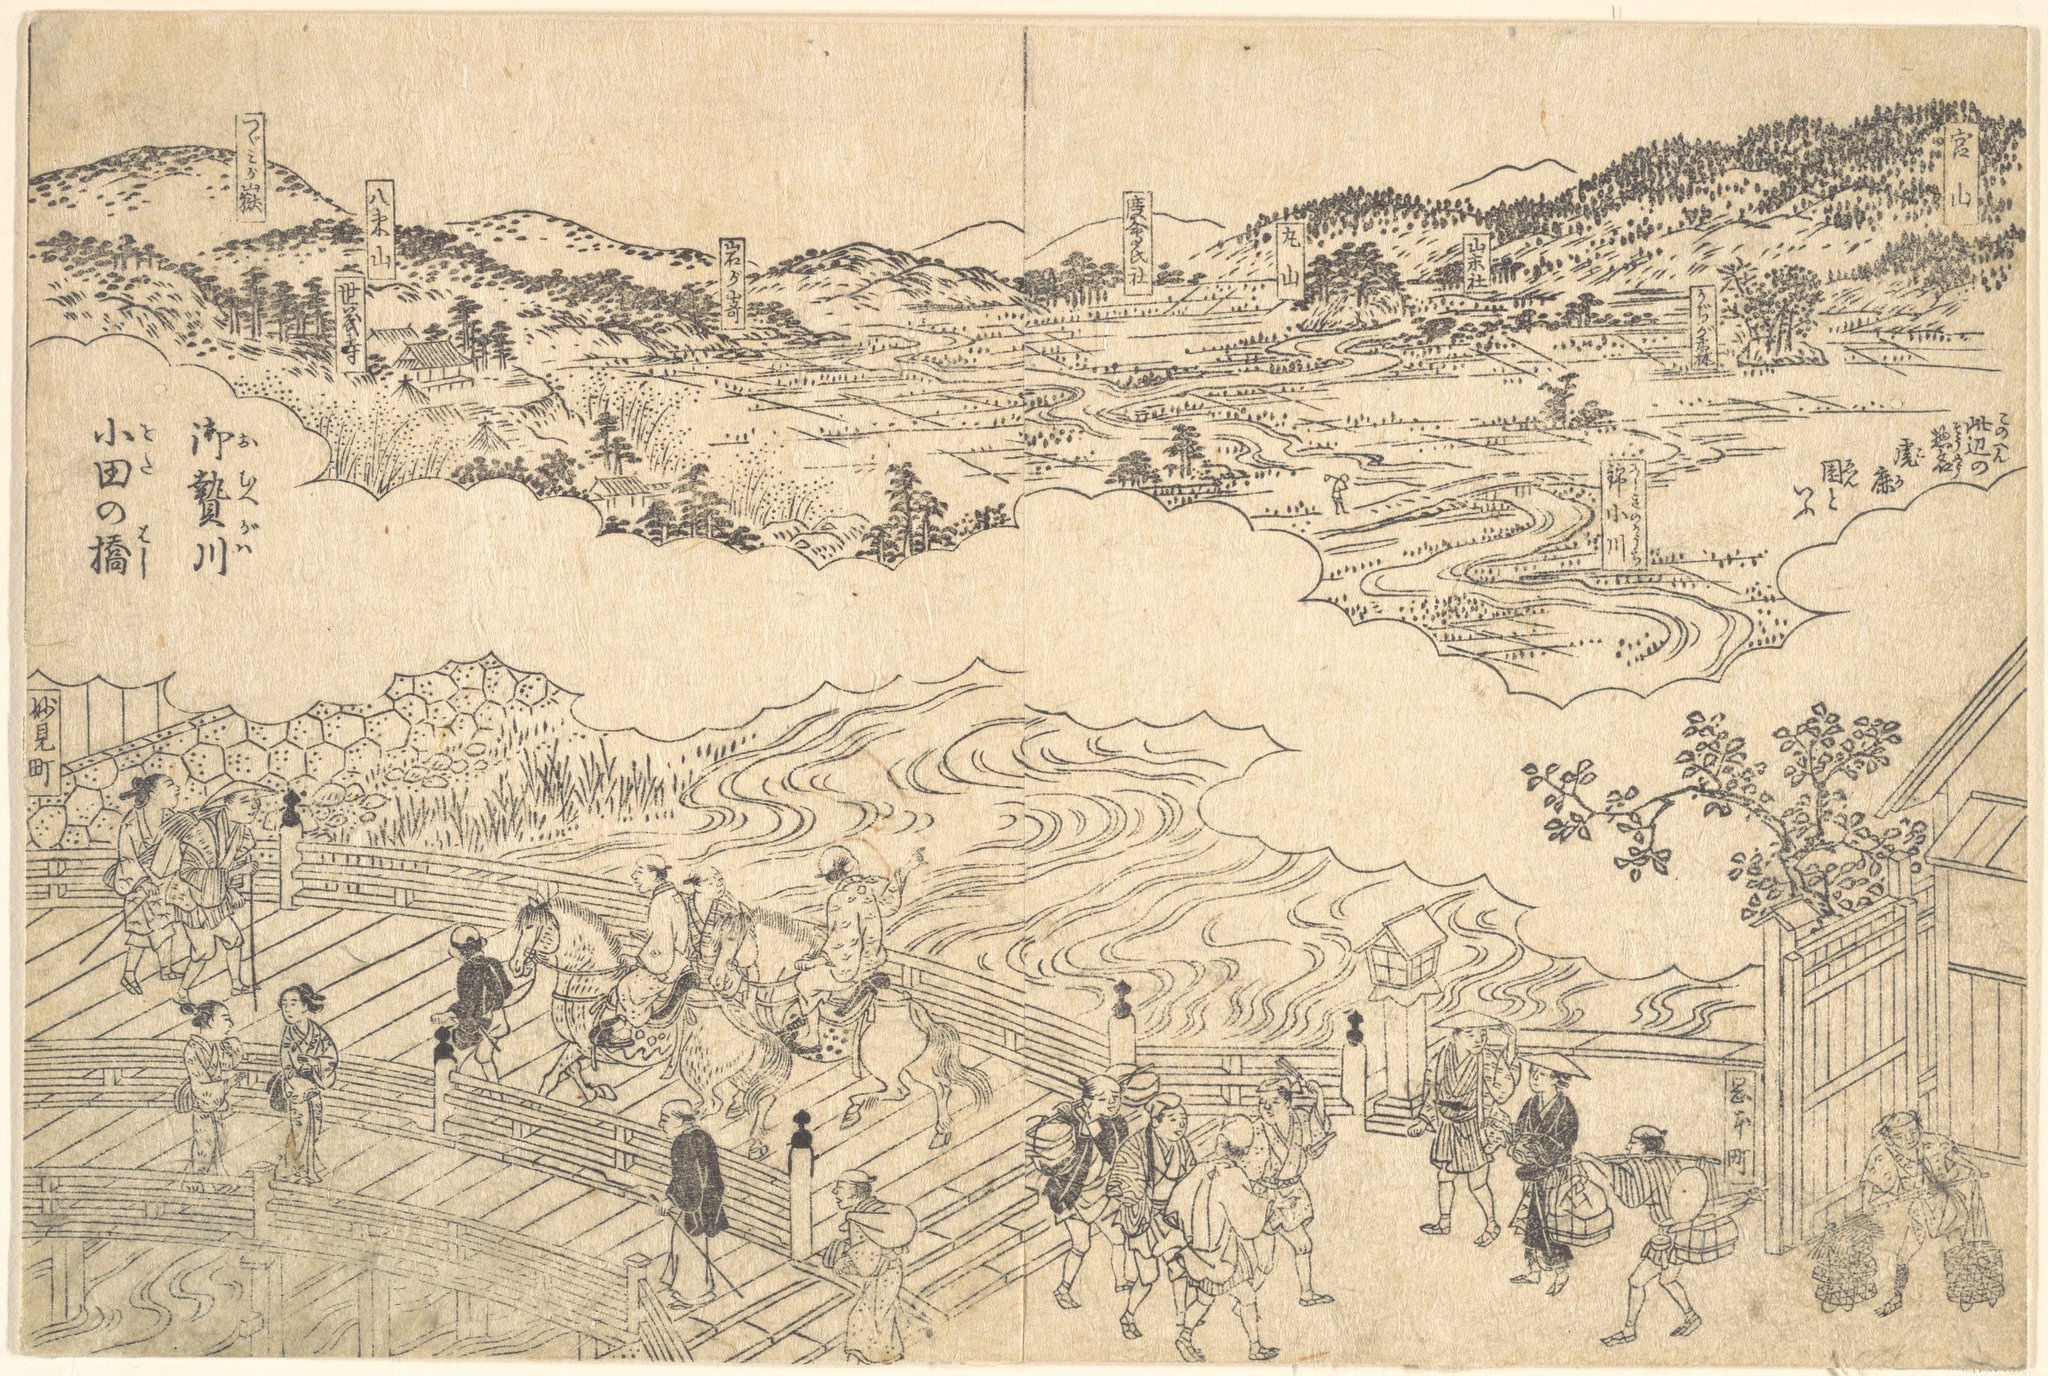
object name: print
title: River of Omue and Bridge of Oda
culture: japanese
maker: unidentified artist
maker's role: artist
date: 1700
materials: ink, paper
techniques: woodblock print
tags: bridges,horses,rivers,trees,crowd